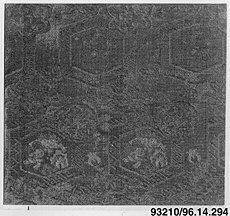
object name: piece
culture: japanese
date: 1701-1900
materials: silk